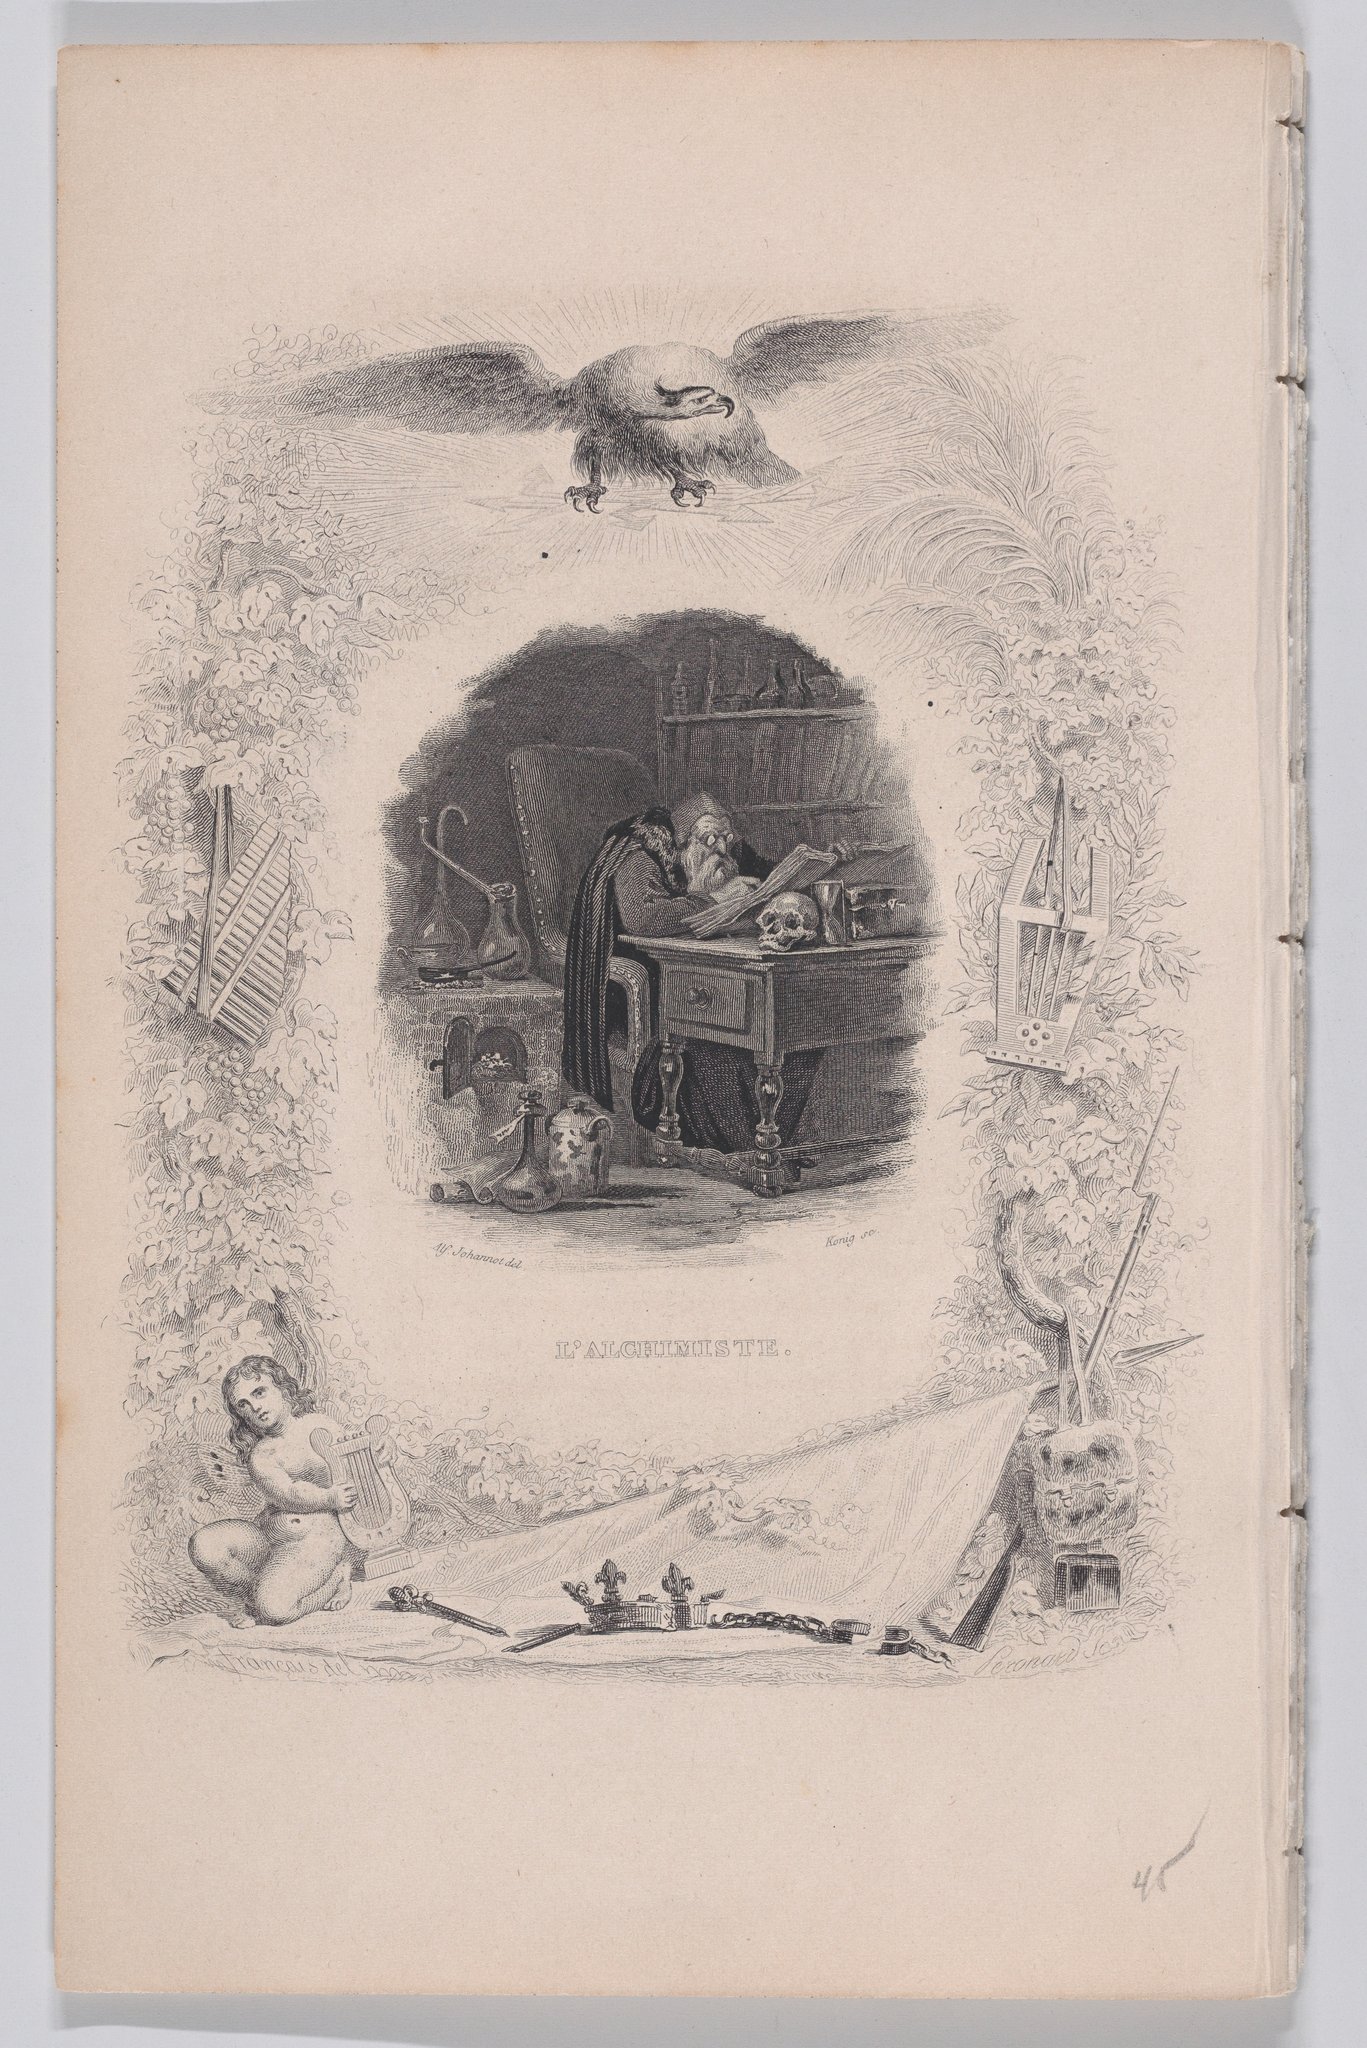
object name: print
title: The Alchemist, from "The Songs of Béranger"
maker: alfred johannot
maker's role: designer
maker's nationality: french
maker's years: 1800-1837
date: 1829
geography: paris